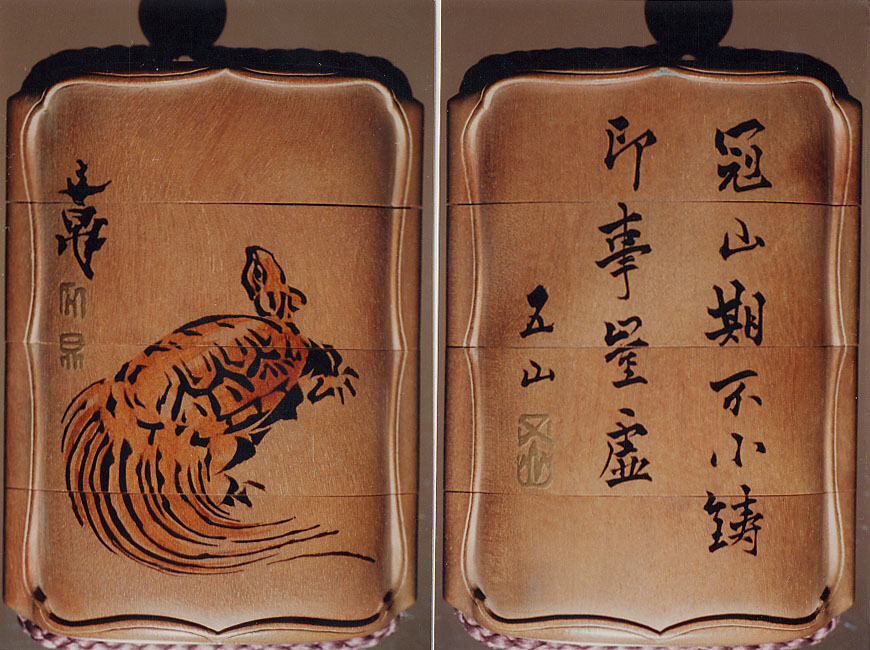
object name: inrō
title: Case (Inrō) with Design of Tortoise beside Seals (obverse); Inscription and Seal (reverse)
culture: japanese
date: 1801-1900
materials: gold, wood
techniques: fundame, hiramakie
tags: turtles